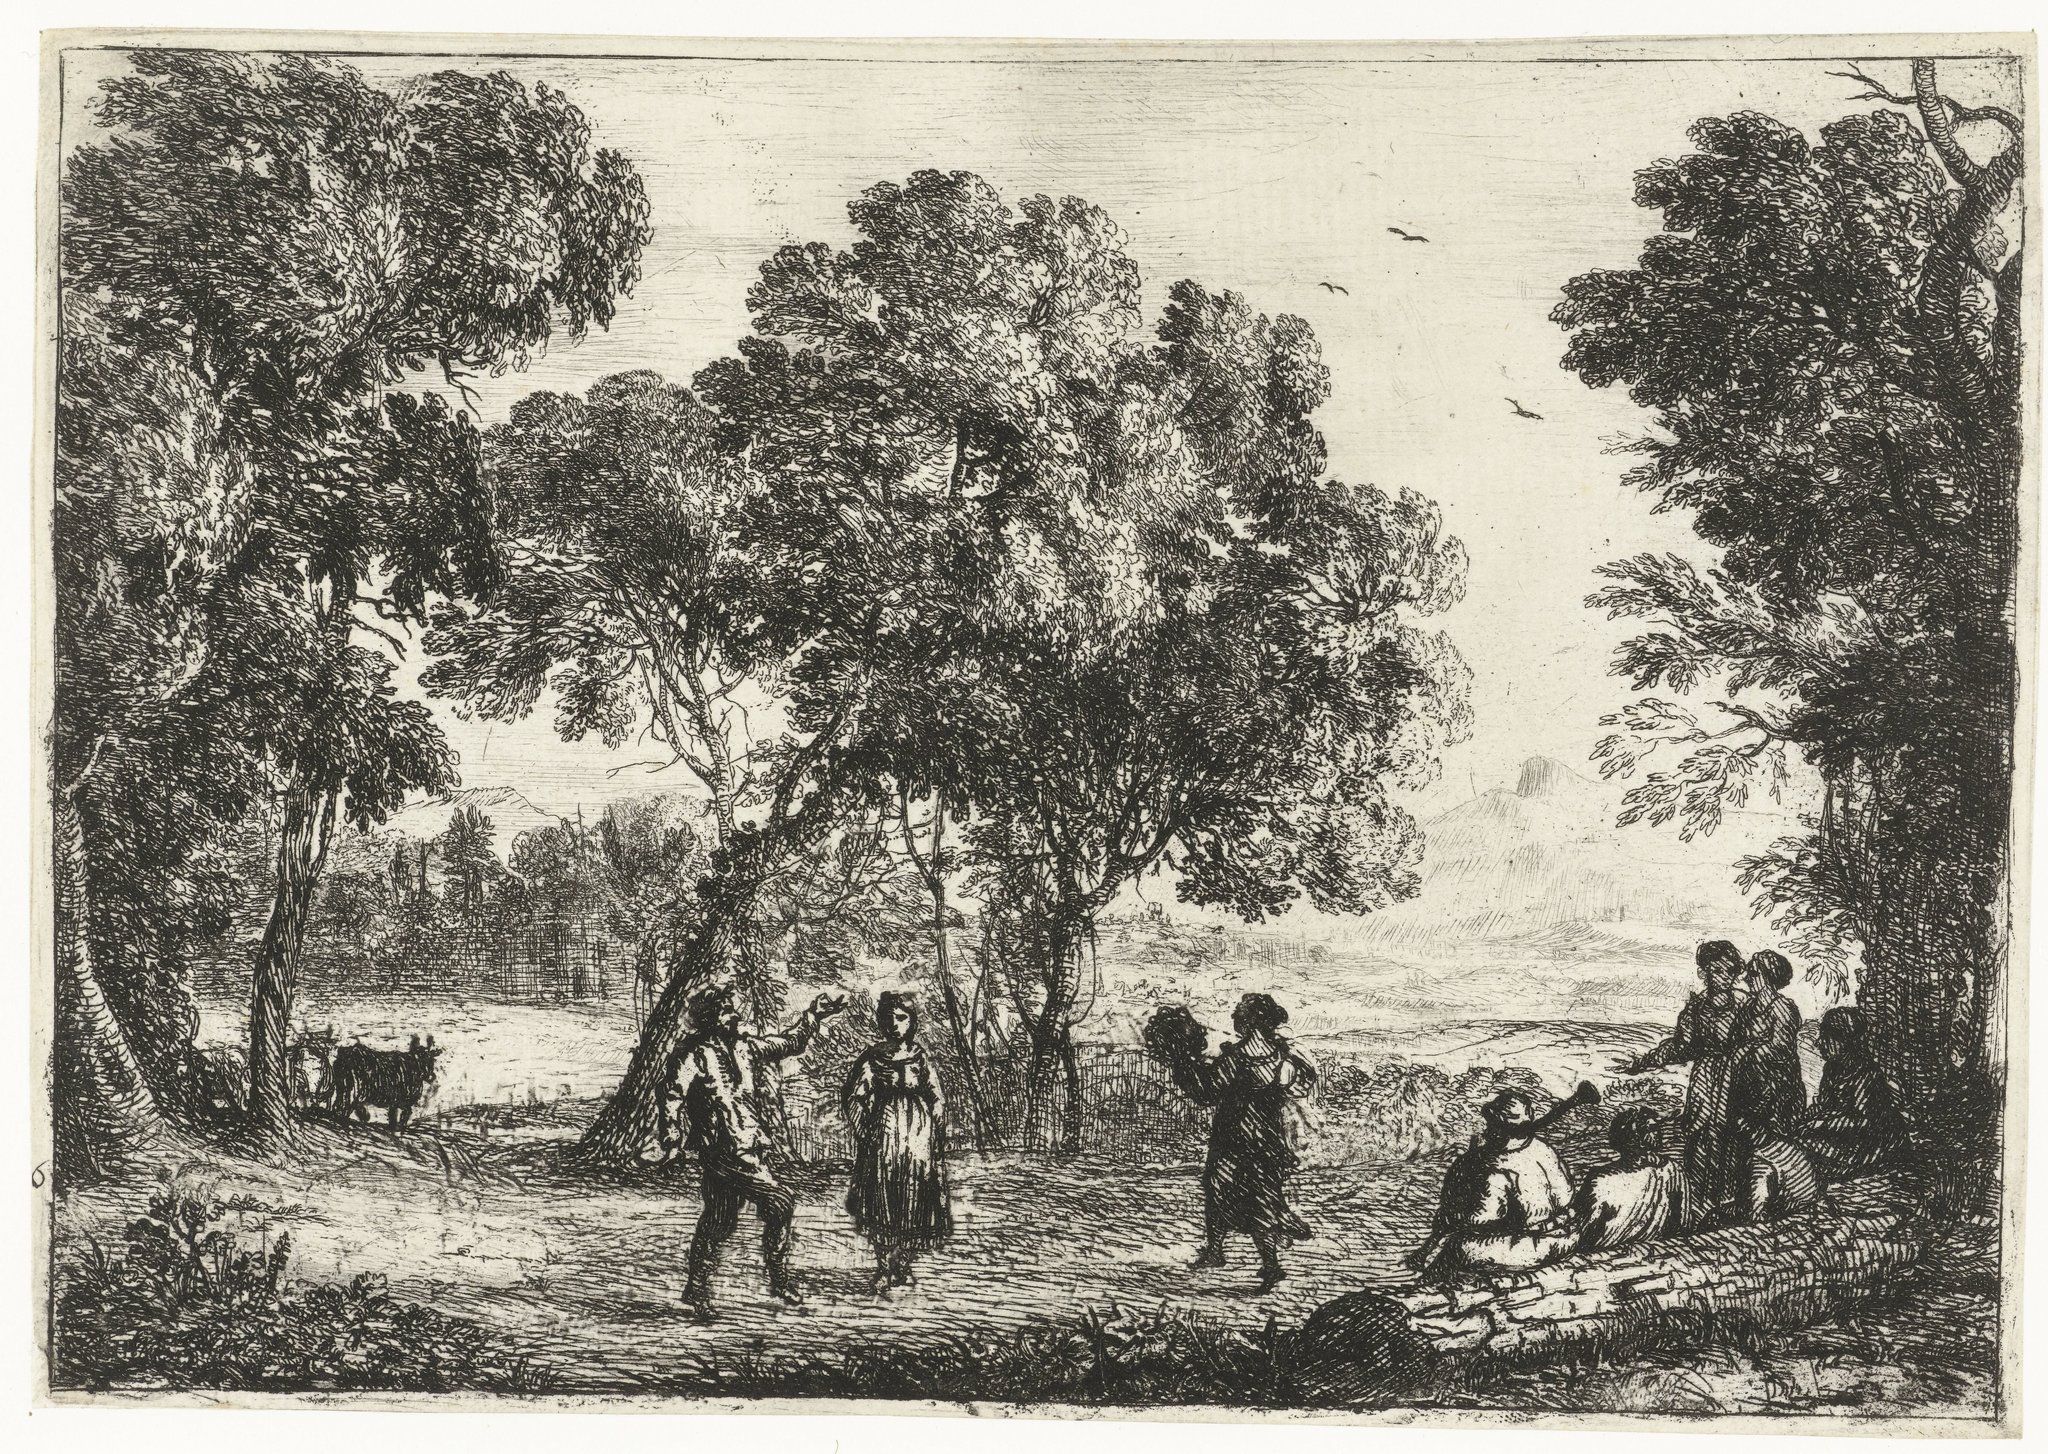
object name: print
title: La Danse sous les arbres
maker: claude lorrain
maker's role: draughtsman, print maker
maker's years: 1604-1682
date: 1635-1639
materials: paper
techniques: etching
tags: dancing, popular music, street music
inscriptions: collector's mark: Lugt 240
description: Een gezelschap op een open plek tussen de bomen. Drie mensen dansen en er wordt muziek gemaakt.